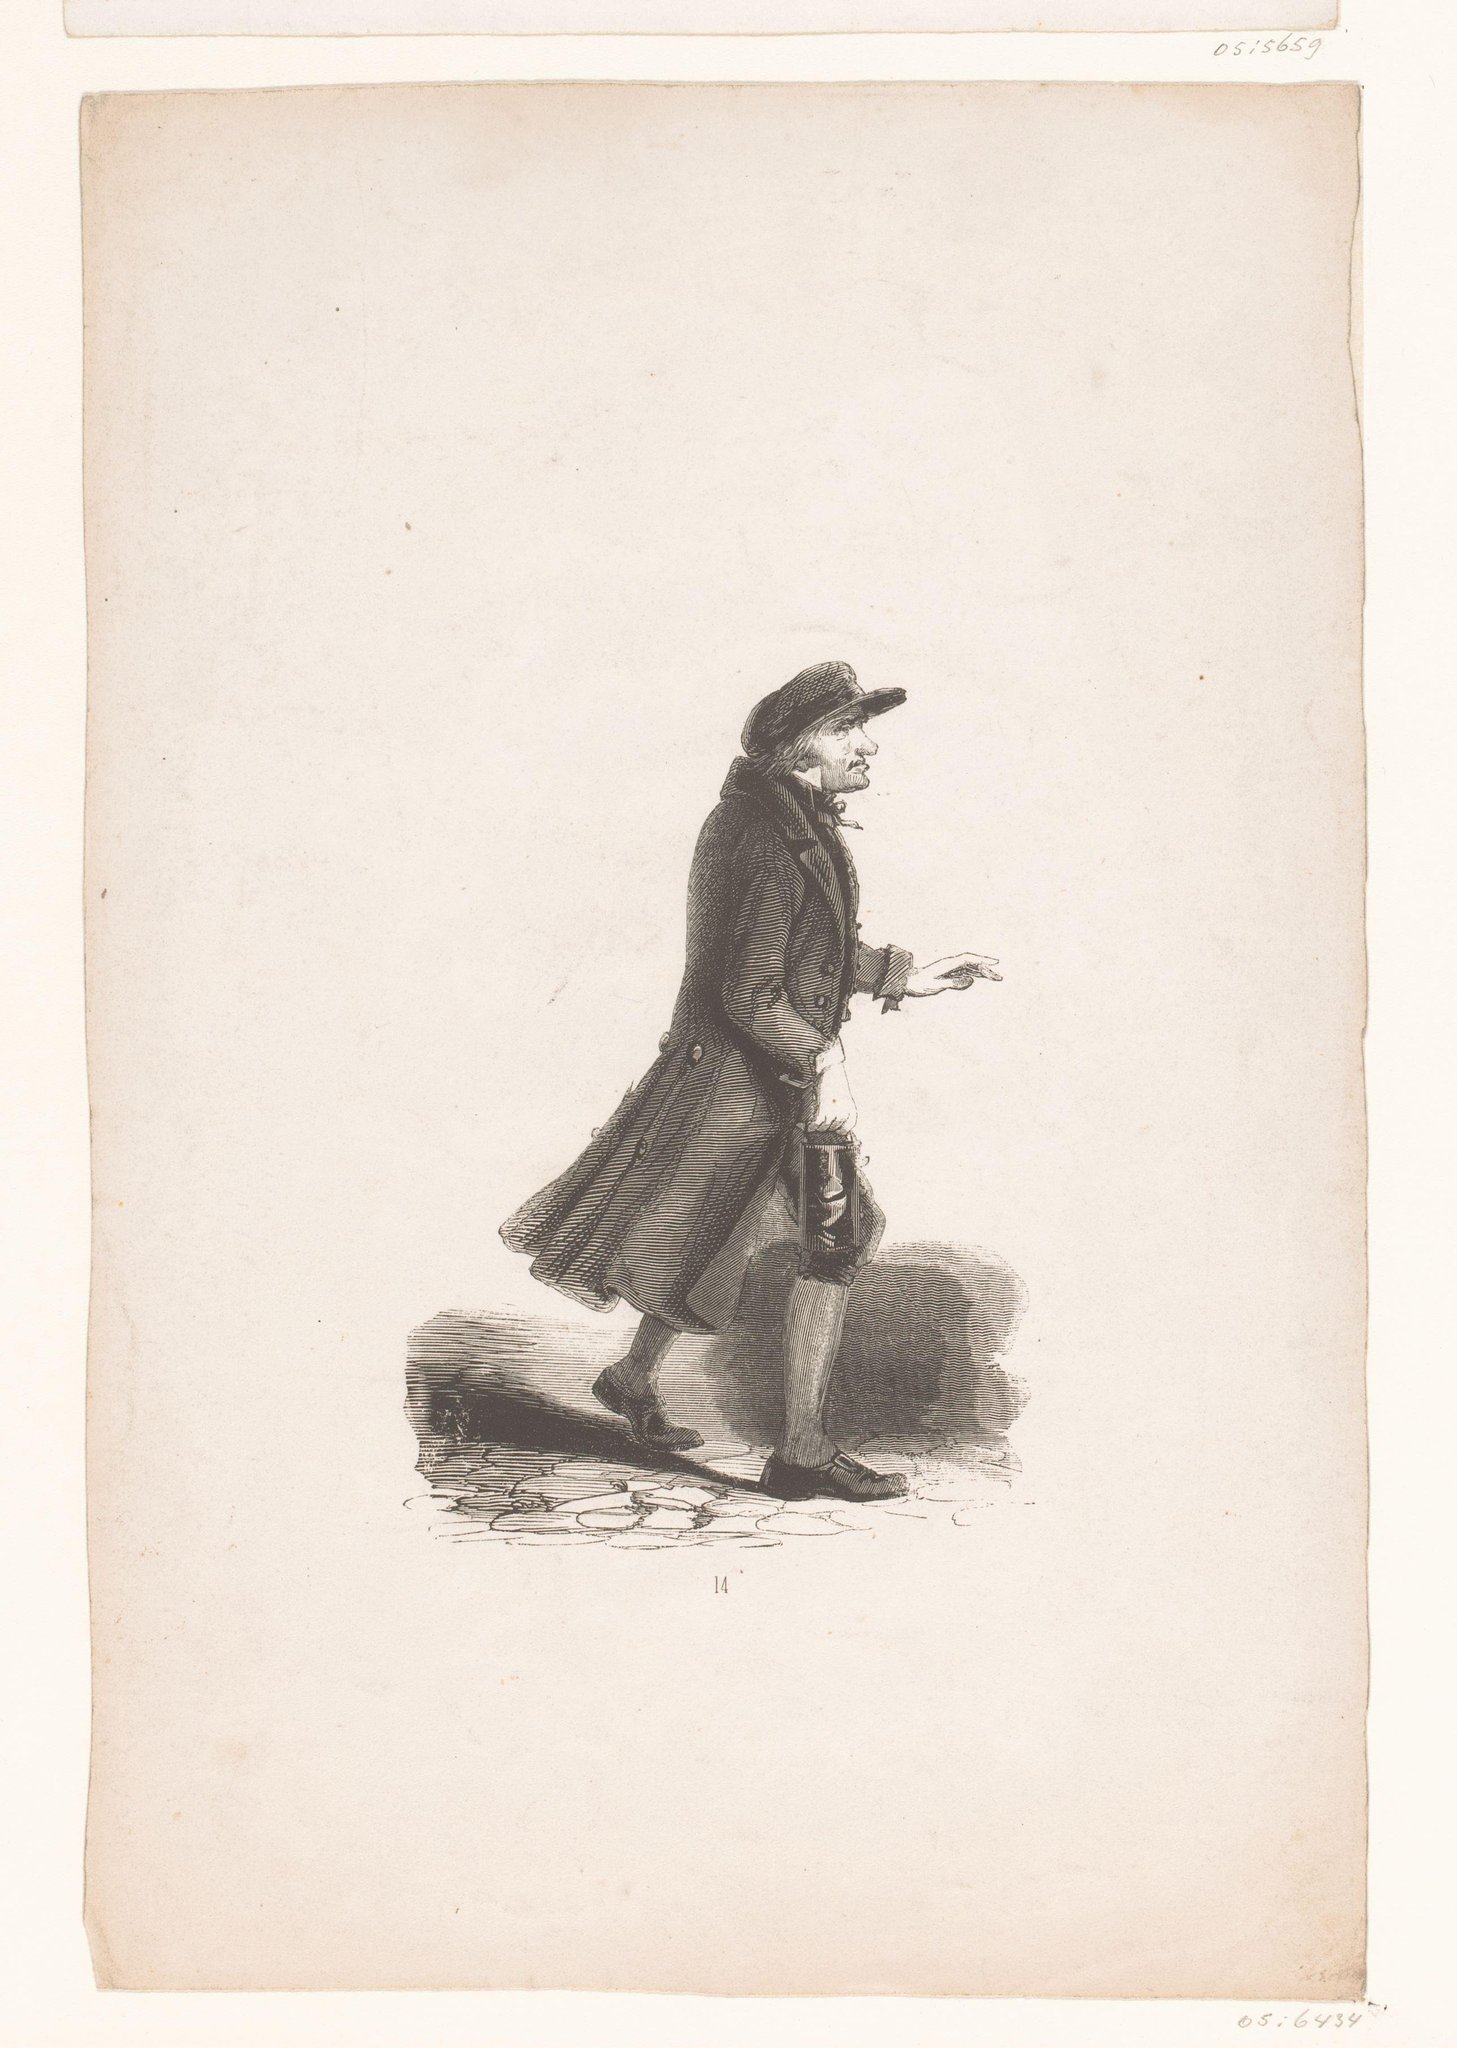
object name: book illustration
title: Man met pet en lange jas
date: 1841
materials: paper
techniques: engraving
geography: the hague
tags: carrying something, coat, adult man, head-gear: cap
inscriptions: collector's mark: Lugt 2228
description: Prent uit: Brown, Henry. De Nederlanden: karakterschetsen, kleederdragten, houding en voorkomen van verschillende standen. Den Haag: Nederlandsche Maatschappij van Schoone Kunsten, 1841.